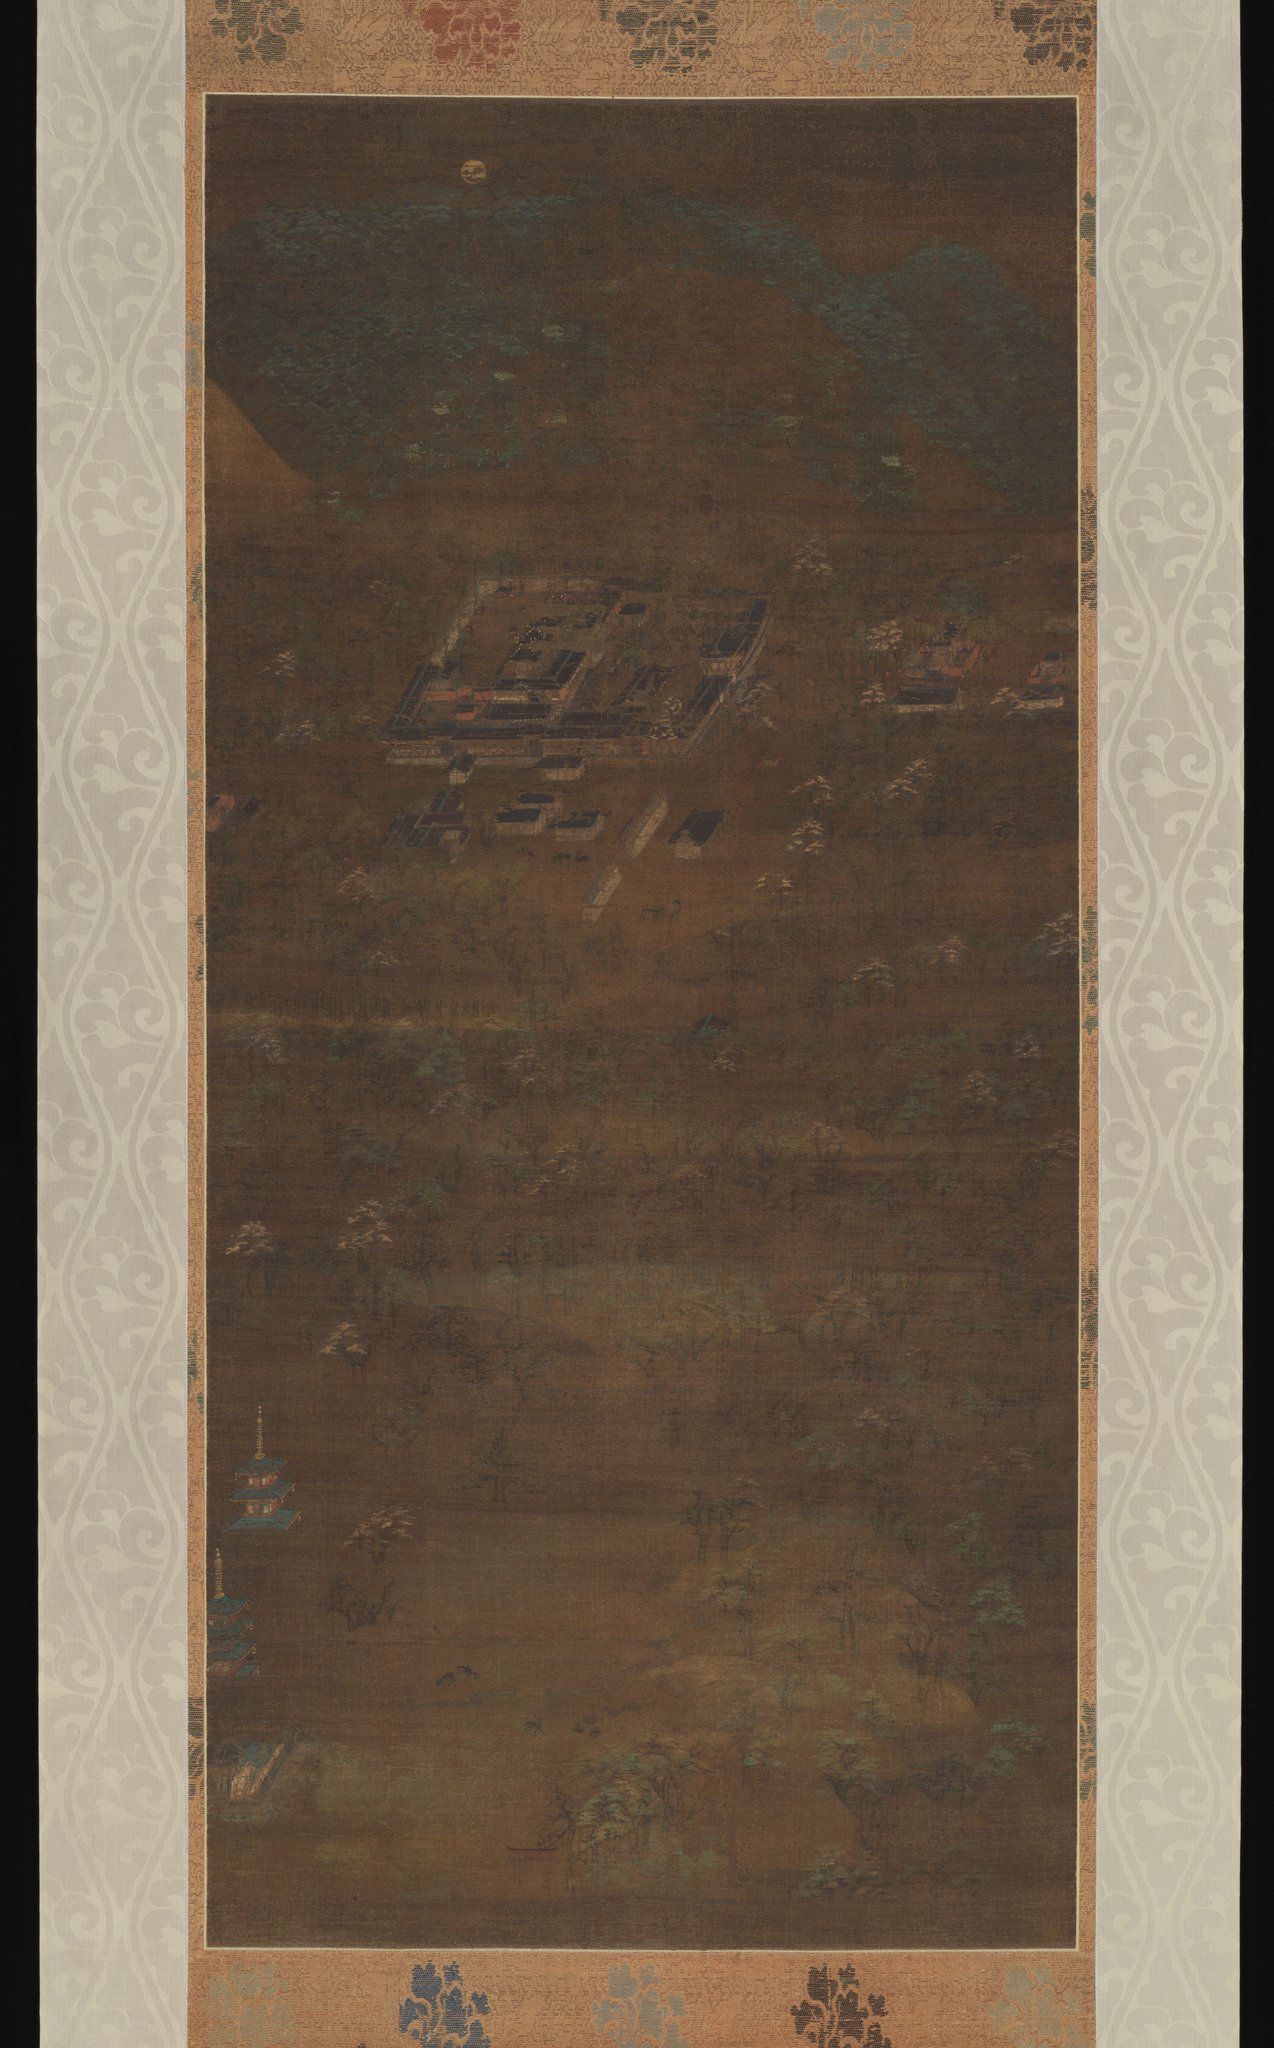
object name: hanging scroll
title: Kasuga Mandala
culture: japanese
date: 1201-1300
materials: gold, ink, silk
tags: temples